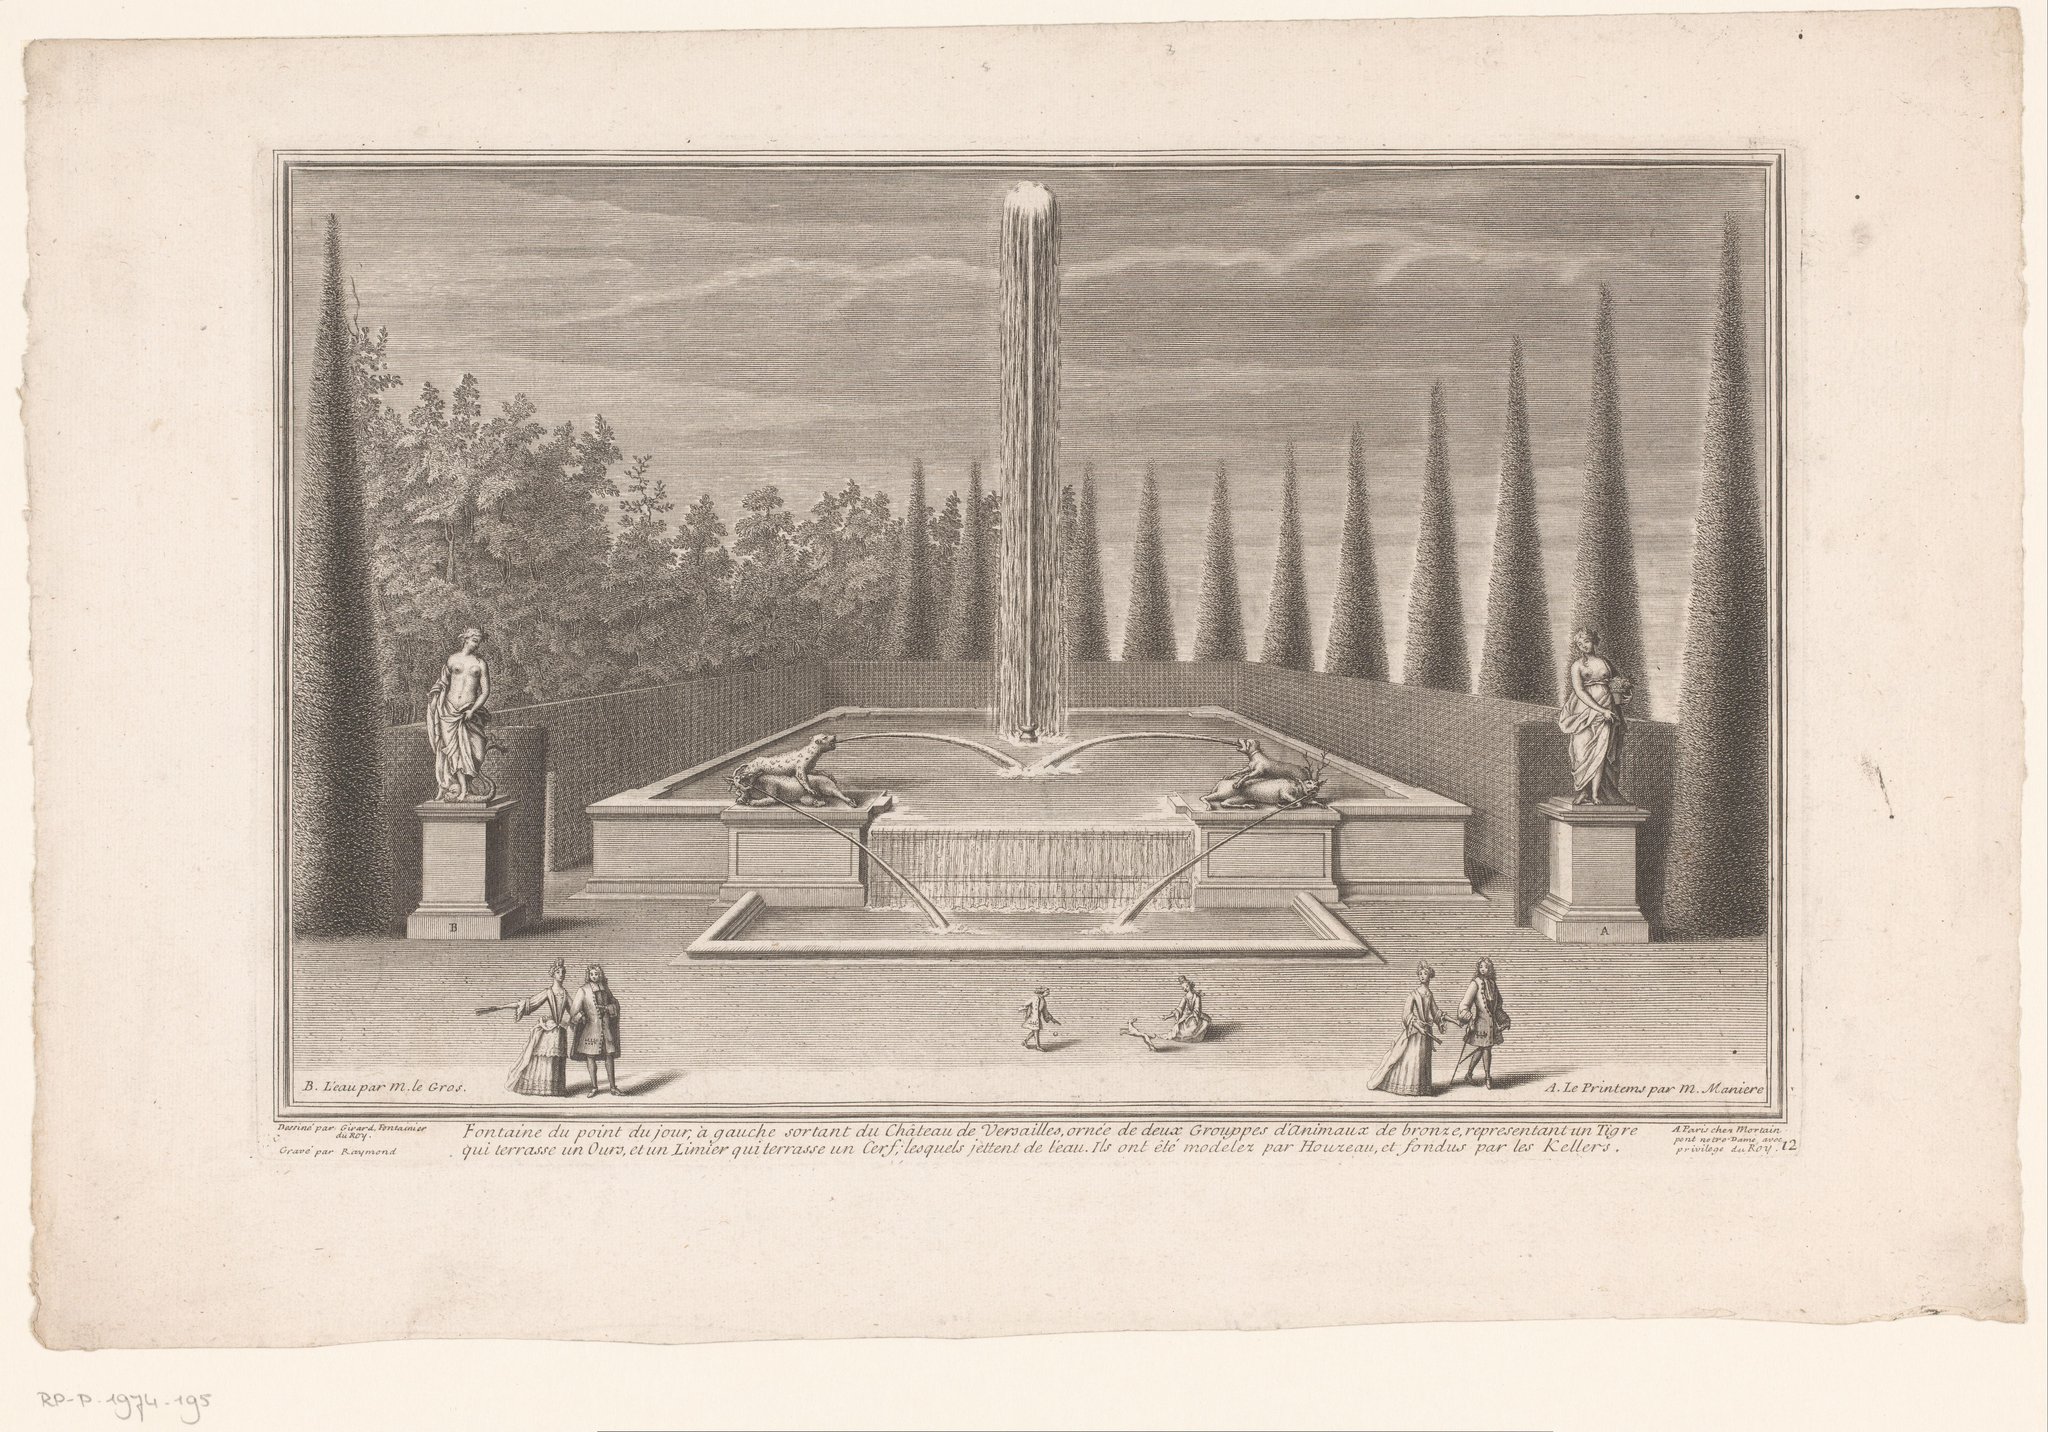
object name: print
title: Fontain du point du jour, à gauche sortant du Château de Versailles, ornée de deux Grouppes d'Animaux de bronze (...)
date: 1705-1747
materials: paper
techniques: engraving, etching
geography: paris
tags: spring, 'ver'; 'primavera' (ripa), water (one of the four elements), statues, sculptures in garden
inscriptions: collector's mark: Lugt 2228, collector's mark: Lugt 2760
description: Links van de fontein een standbeeld, personificatie van water. Rechts van de fontein een standbeeld, personificatie van lente. Op de fontein twee groepen dieren: links een tijger met een beer, rechts een zweethond met een hert.